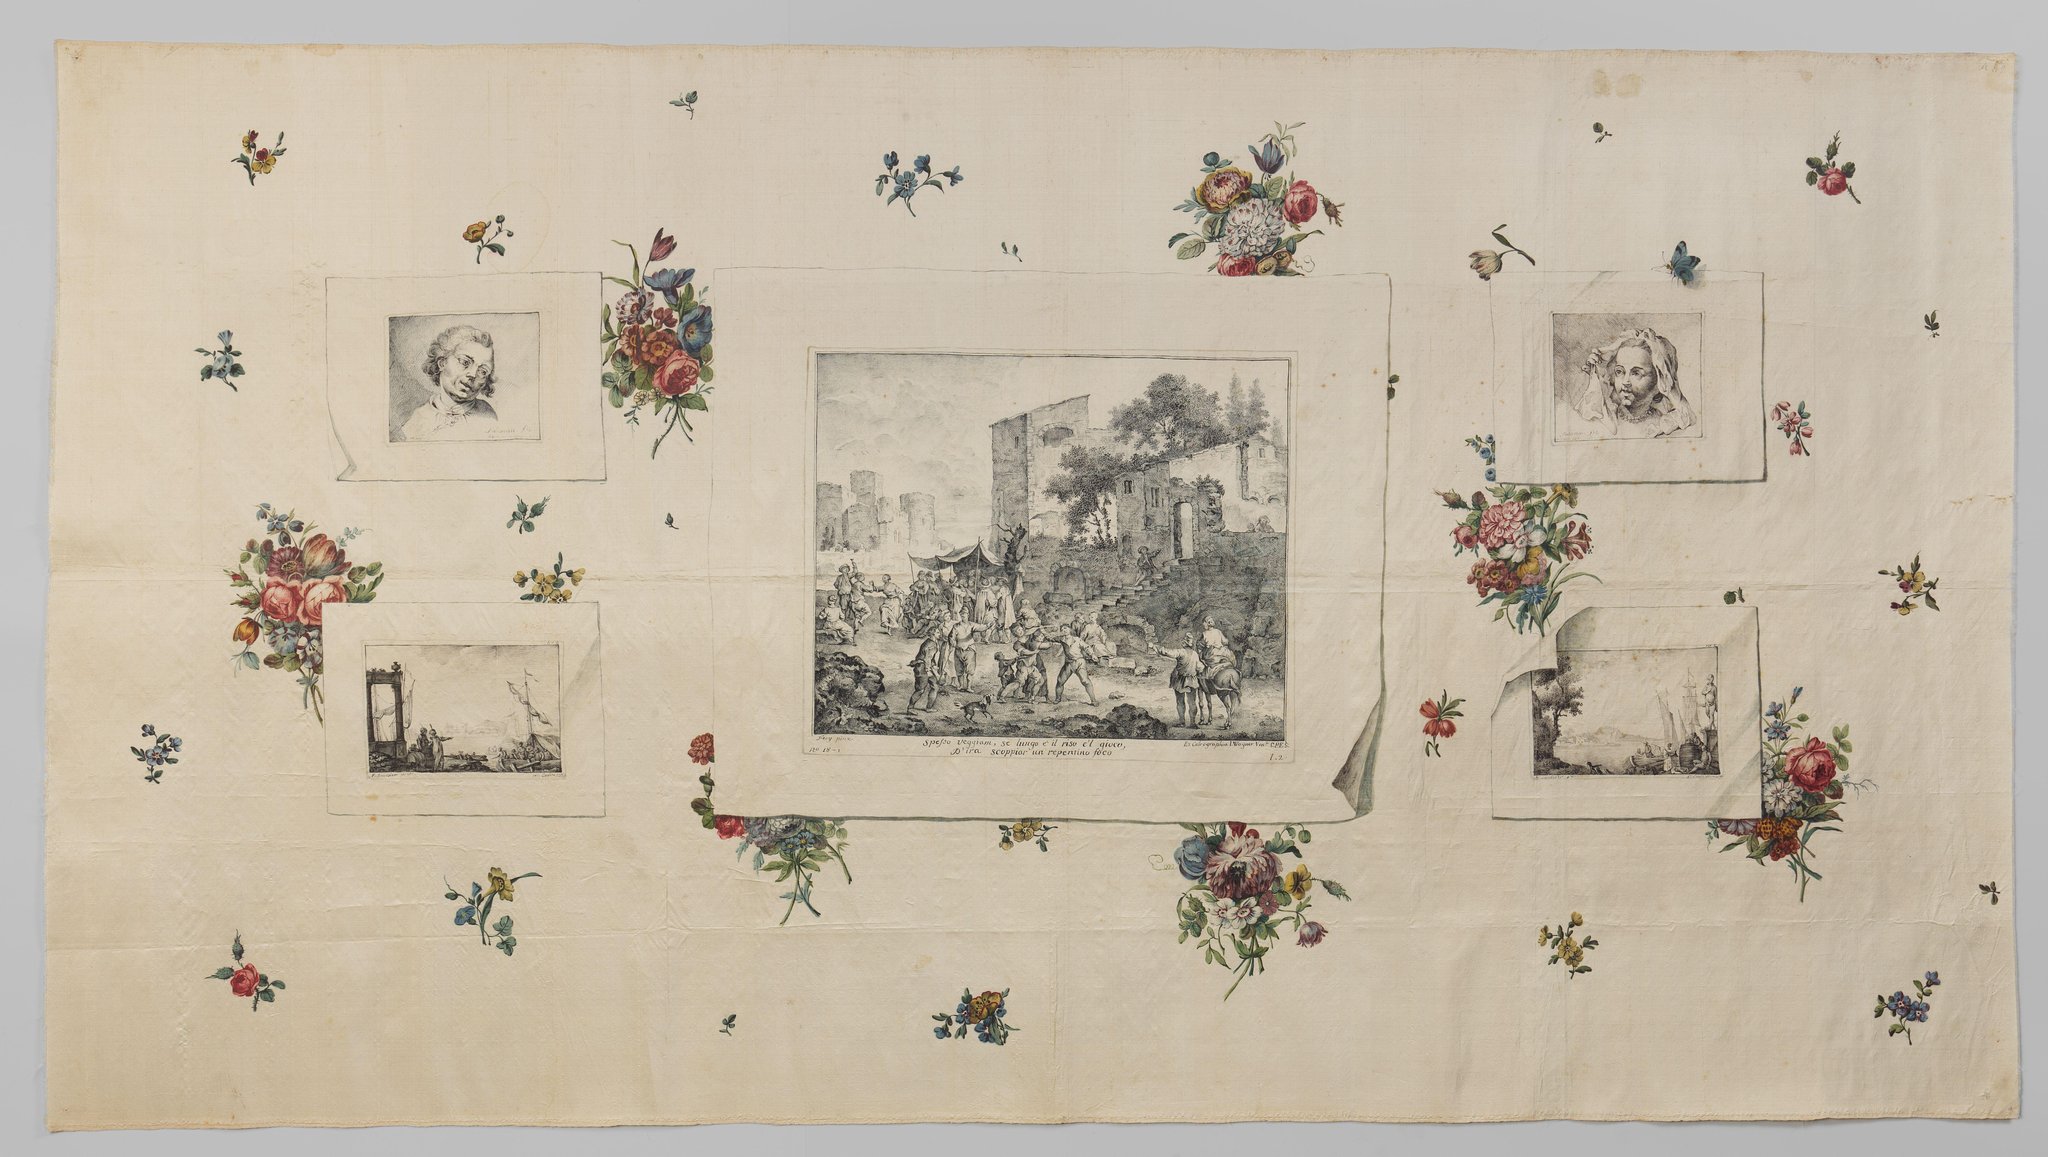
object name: silk textile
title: Zijdeweefsel, beschilderd à trompe l'oeil met vijf prenten tegen een achtergrond van bloemen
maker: Anonymous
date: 1770-1790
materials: silk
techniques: painted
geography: meissen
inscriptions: signature: ‘F.: DUVIVIER p:cit’, signature: ‘Is... Louis sculp’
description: Zijdeweefsel, beschilderd à trompe l'oeil, met vijf prenten tegen een achtergrond van veelkleurige strooibloemen en boeketten. De centrale prent stelt een landschap met ruïnes en figuren voor. Ter weerszijden hiervan twee havengezichten en twee portretten.